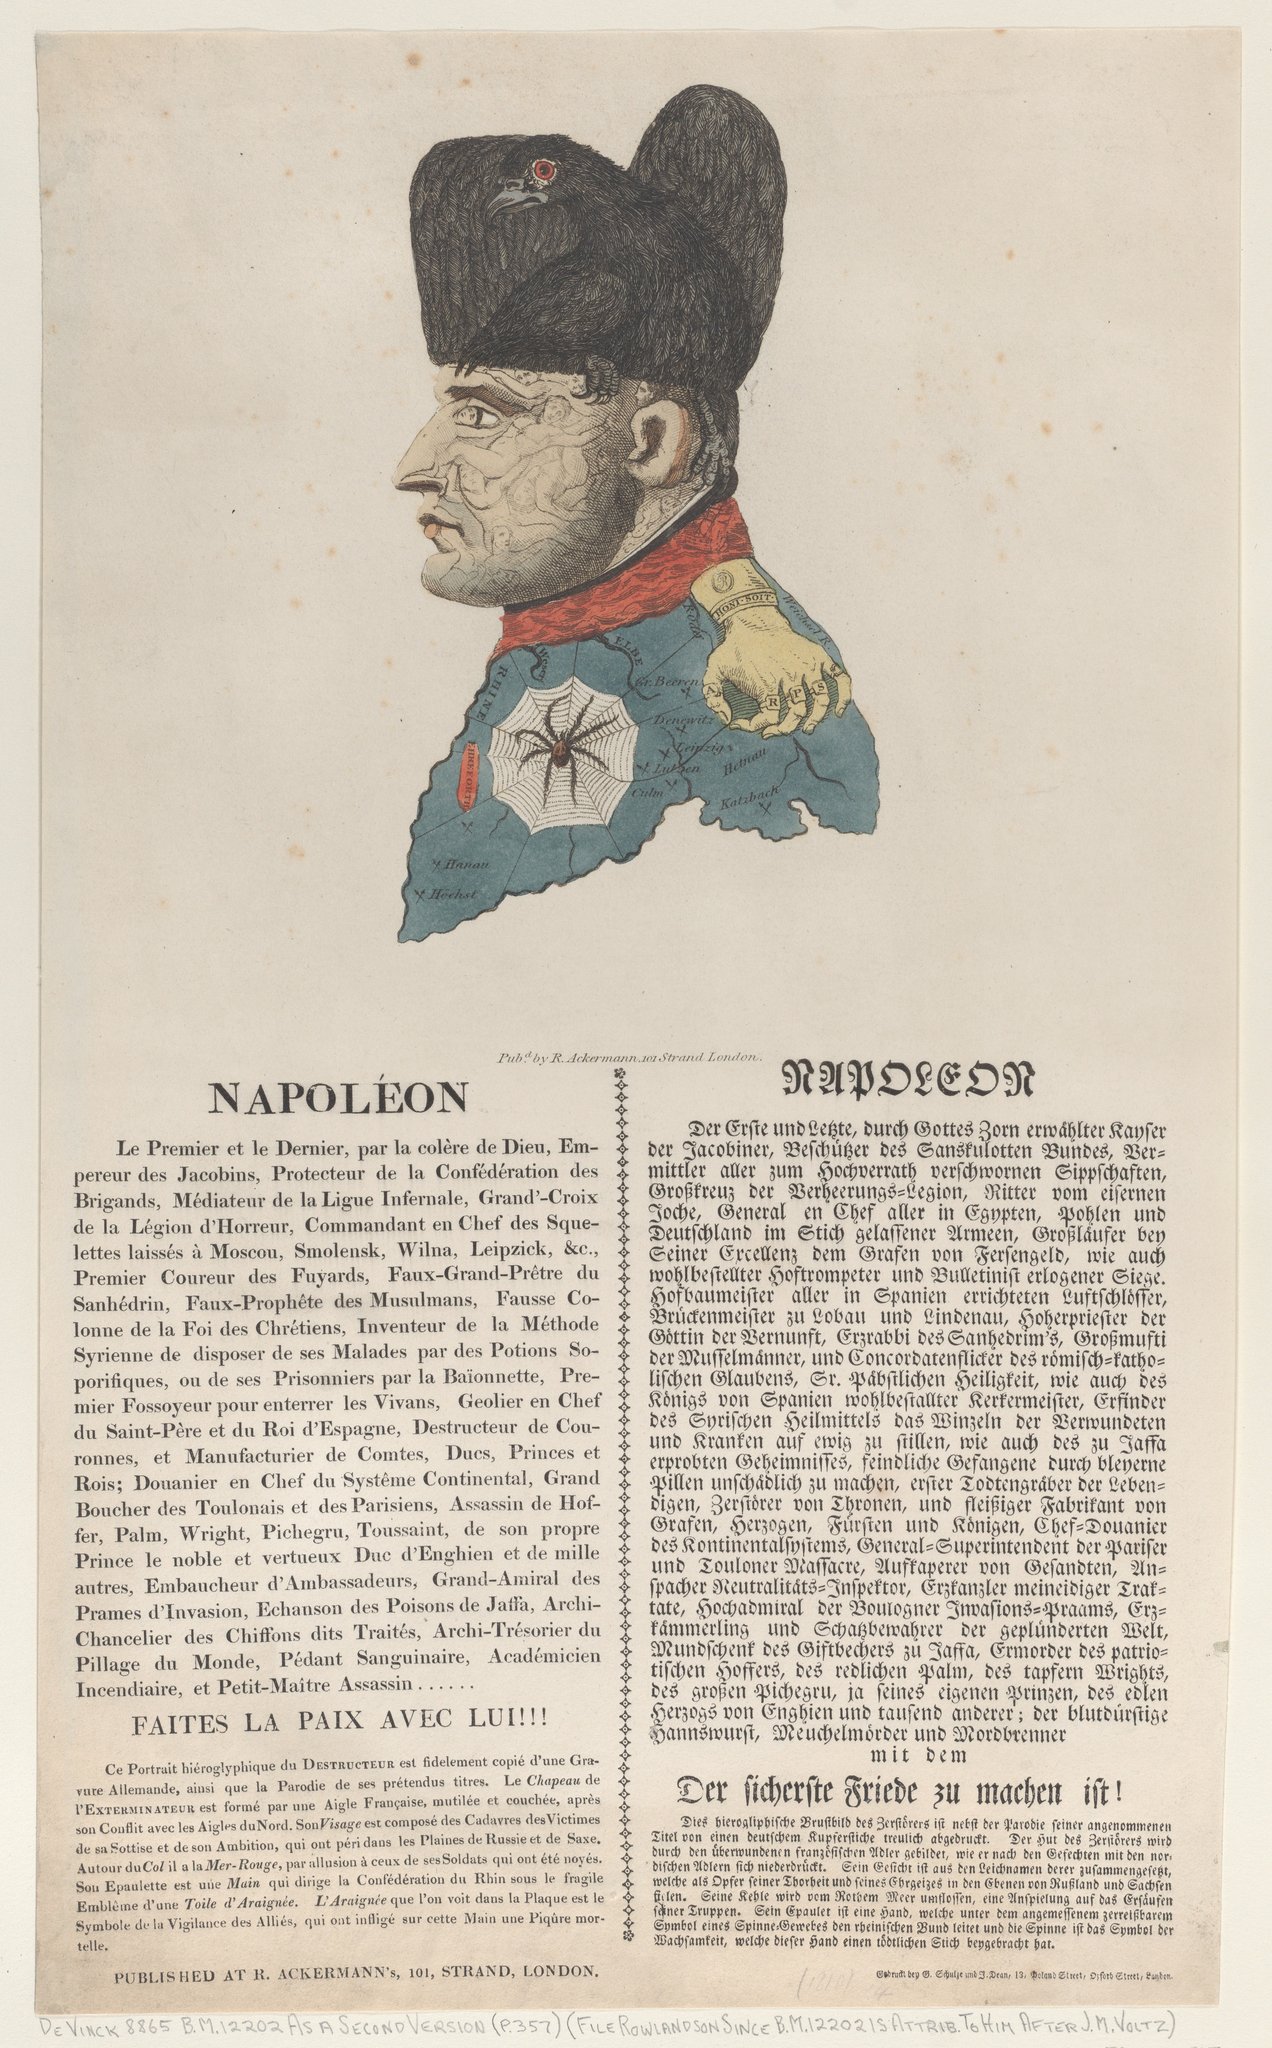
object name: print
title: Napoleon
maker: thomas rowlandson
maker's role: artist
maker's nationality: british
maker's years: 1757-1827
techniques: etching, letterpress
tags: eagles,satire,napoleon i,hands,spiders